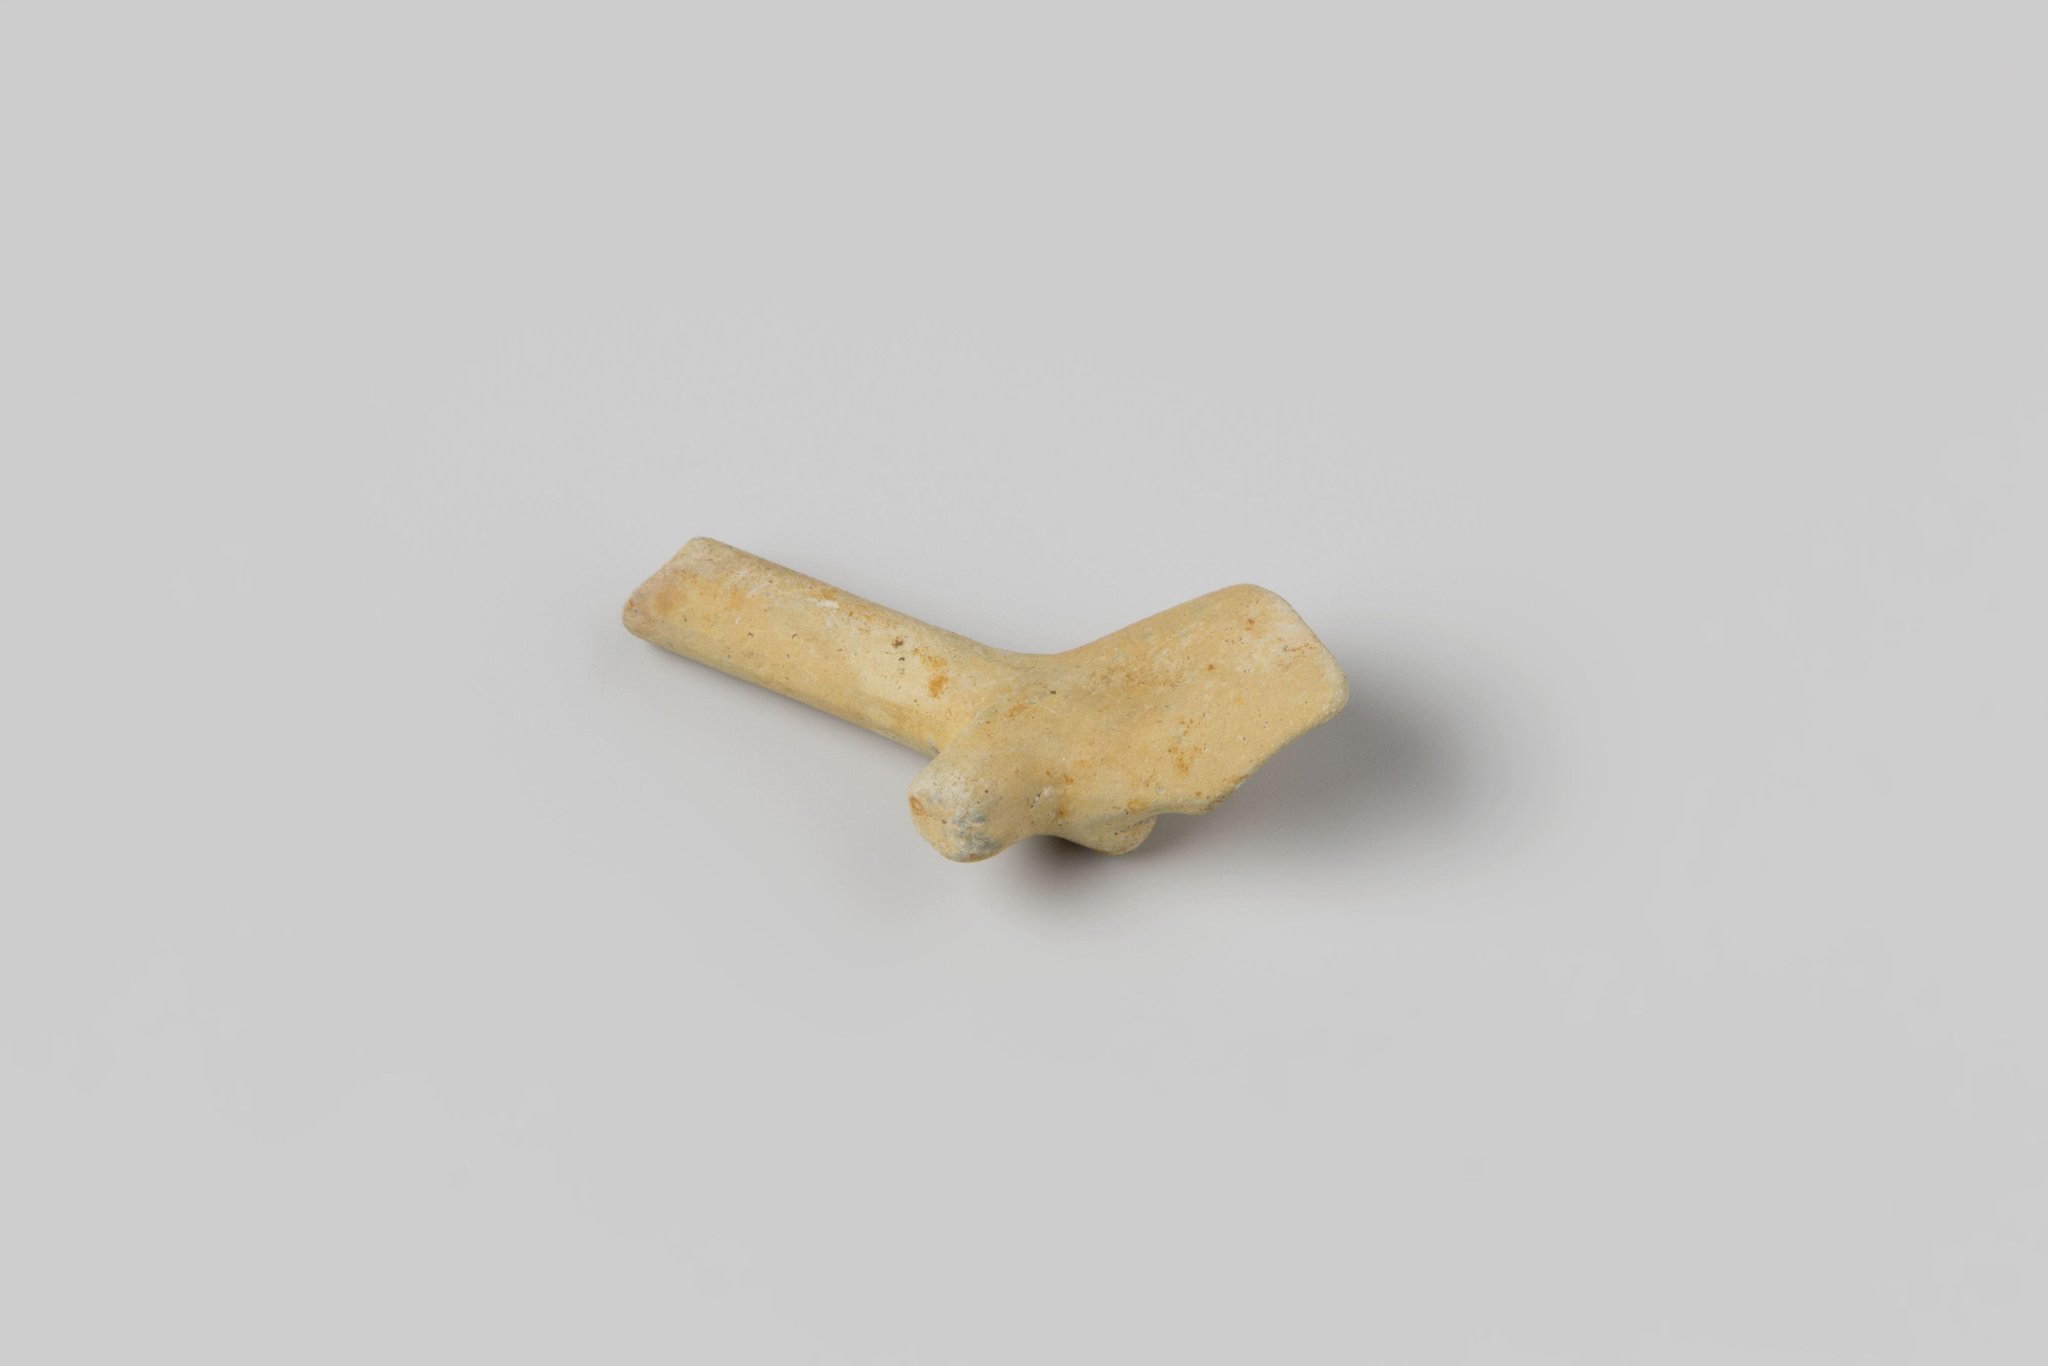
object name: pipe bowl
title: Fragment pijpenkop uit het wrak van de Oost-Indiëvaarder Hollandia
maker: Anonymous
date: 1700-1743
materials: clay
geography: netherlands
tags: verenigde oostindische compagnie, hollandia (schip), annet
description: Pipe, bowl, heelmark illegible; fragment.